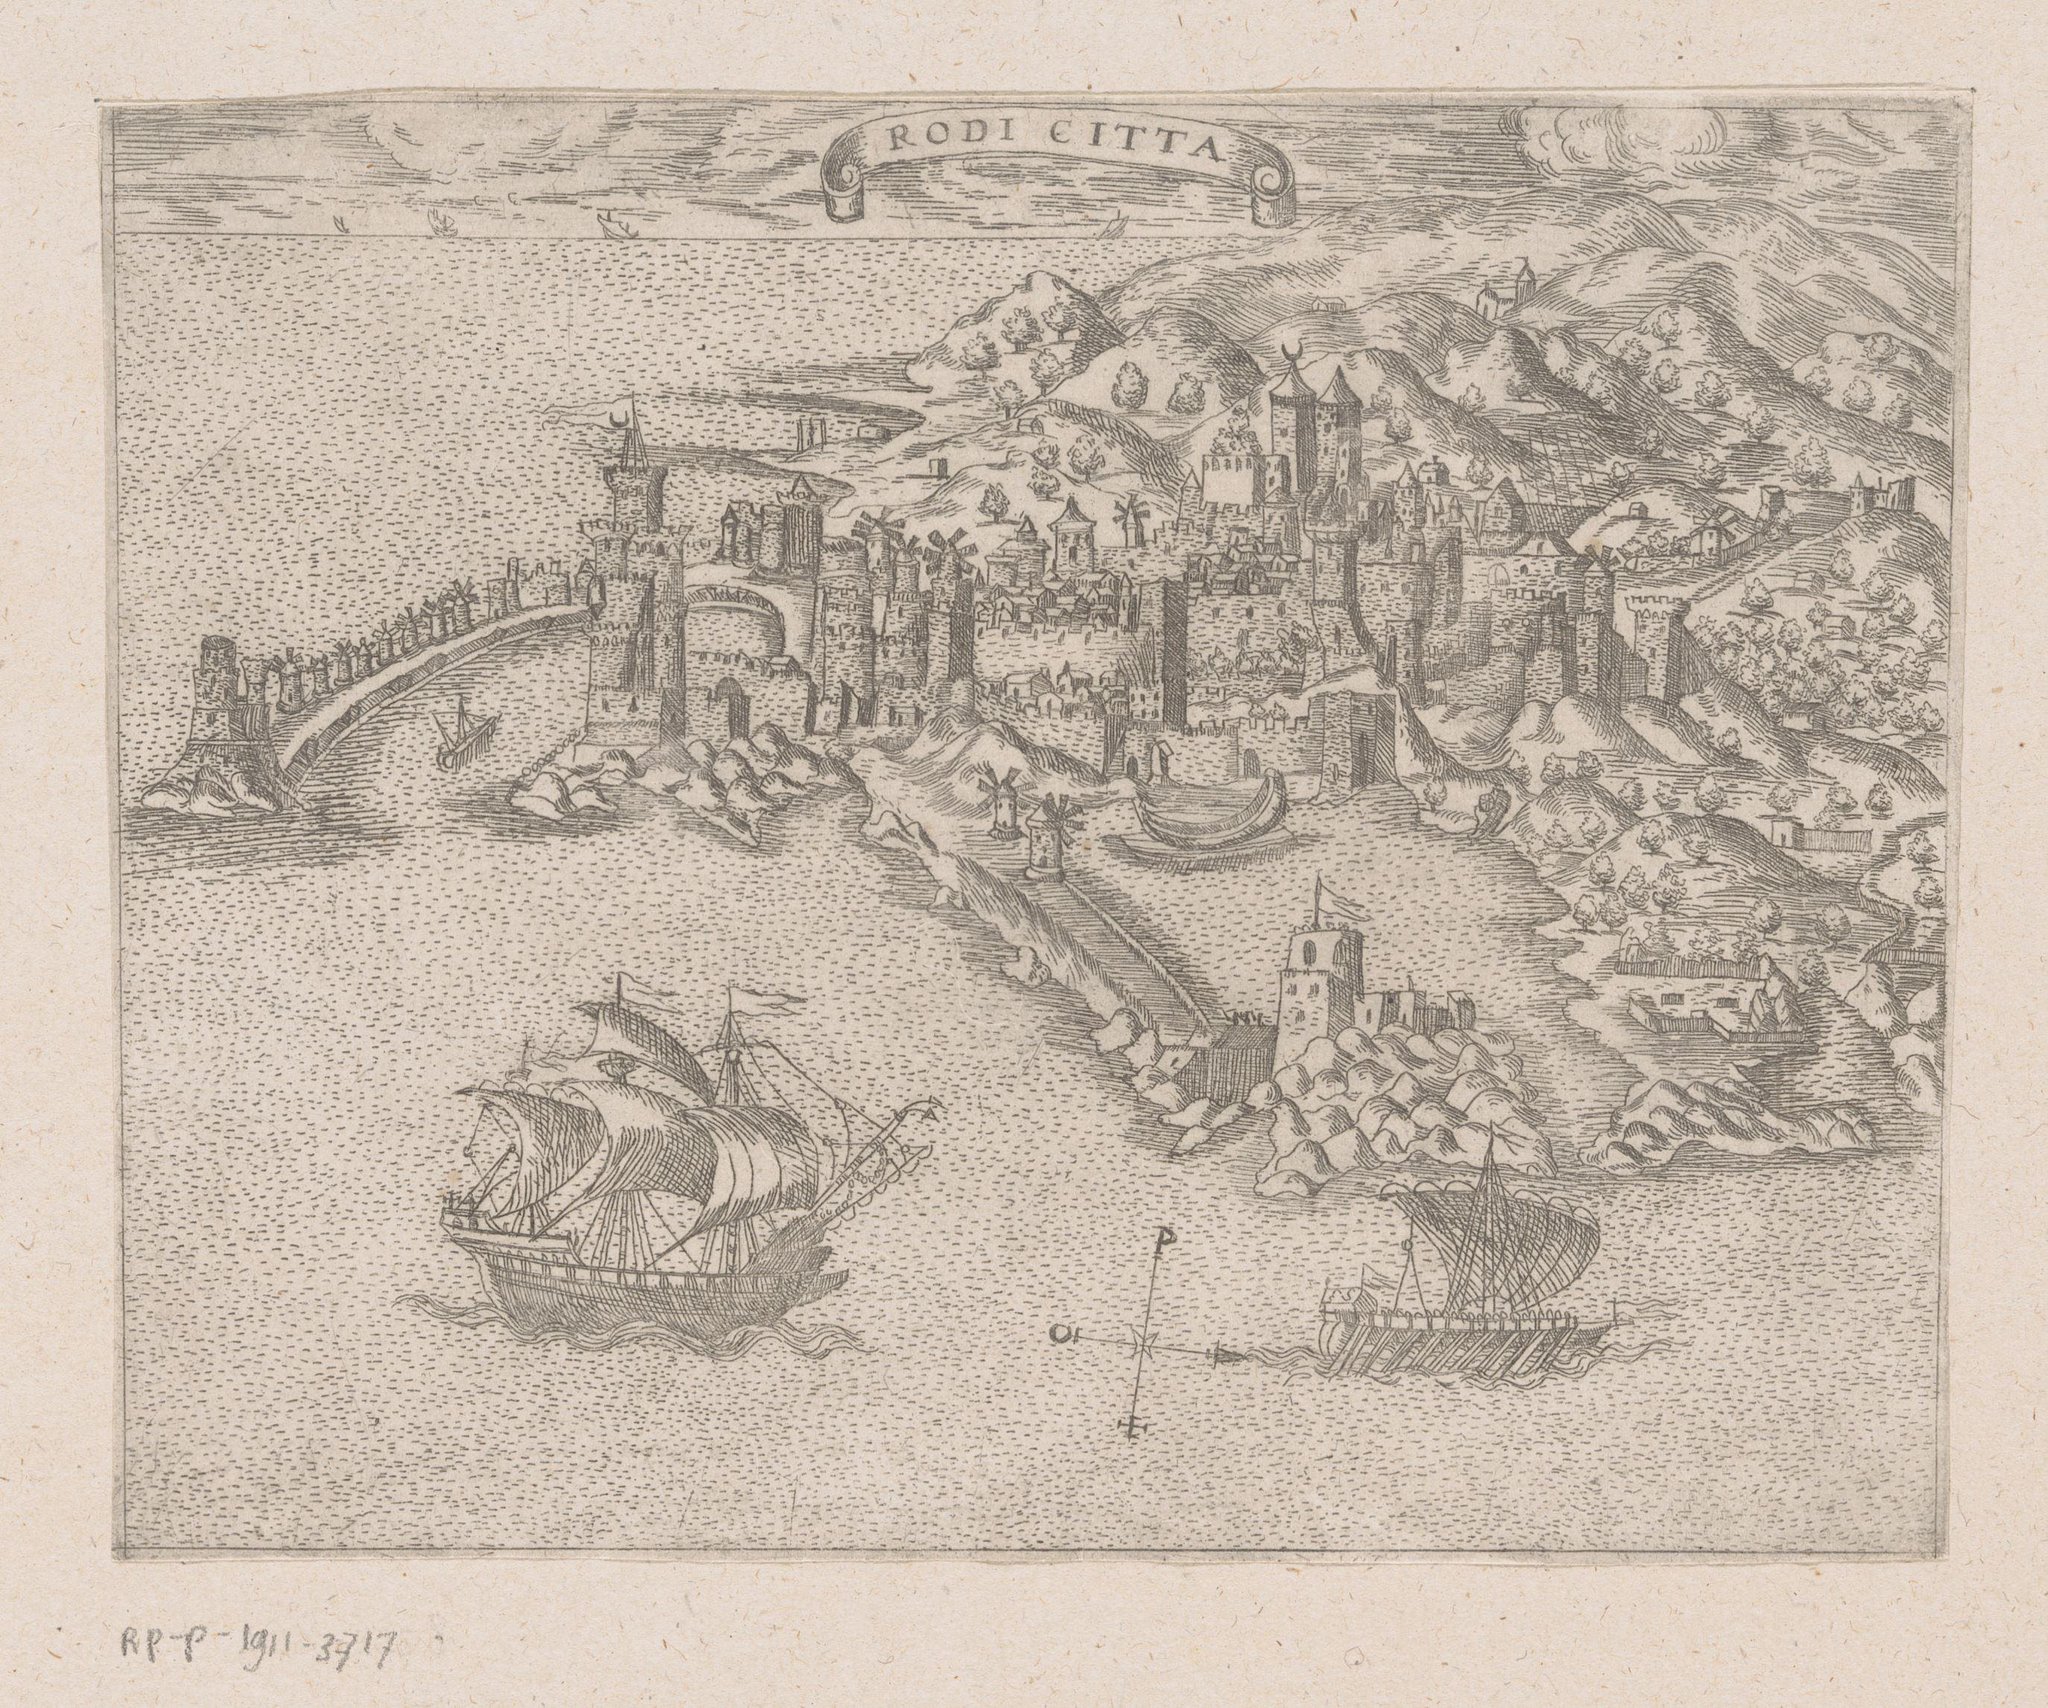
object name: print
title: Gezicht op de stad Rodos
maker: Anonymous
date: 1550-1600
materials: paper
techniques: etching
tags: harbour, city-view, and landscape with man-made constructions, island, coast